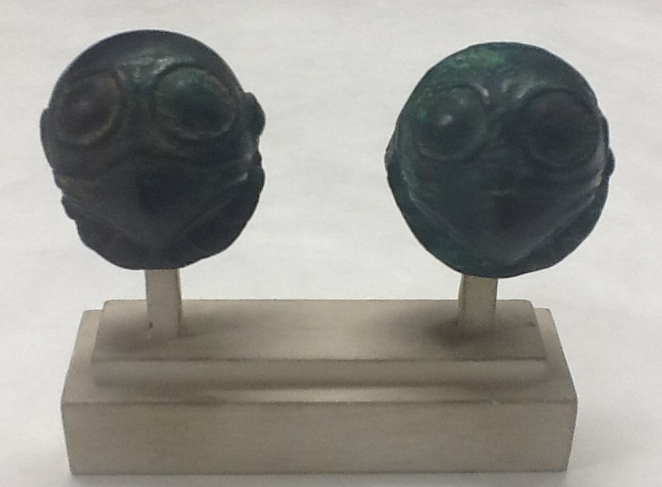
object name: ornament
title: One of a pair of Bird-Head Ornaments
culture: chinese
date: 300-1 BCE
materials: bronze